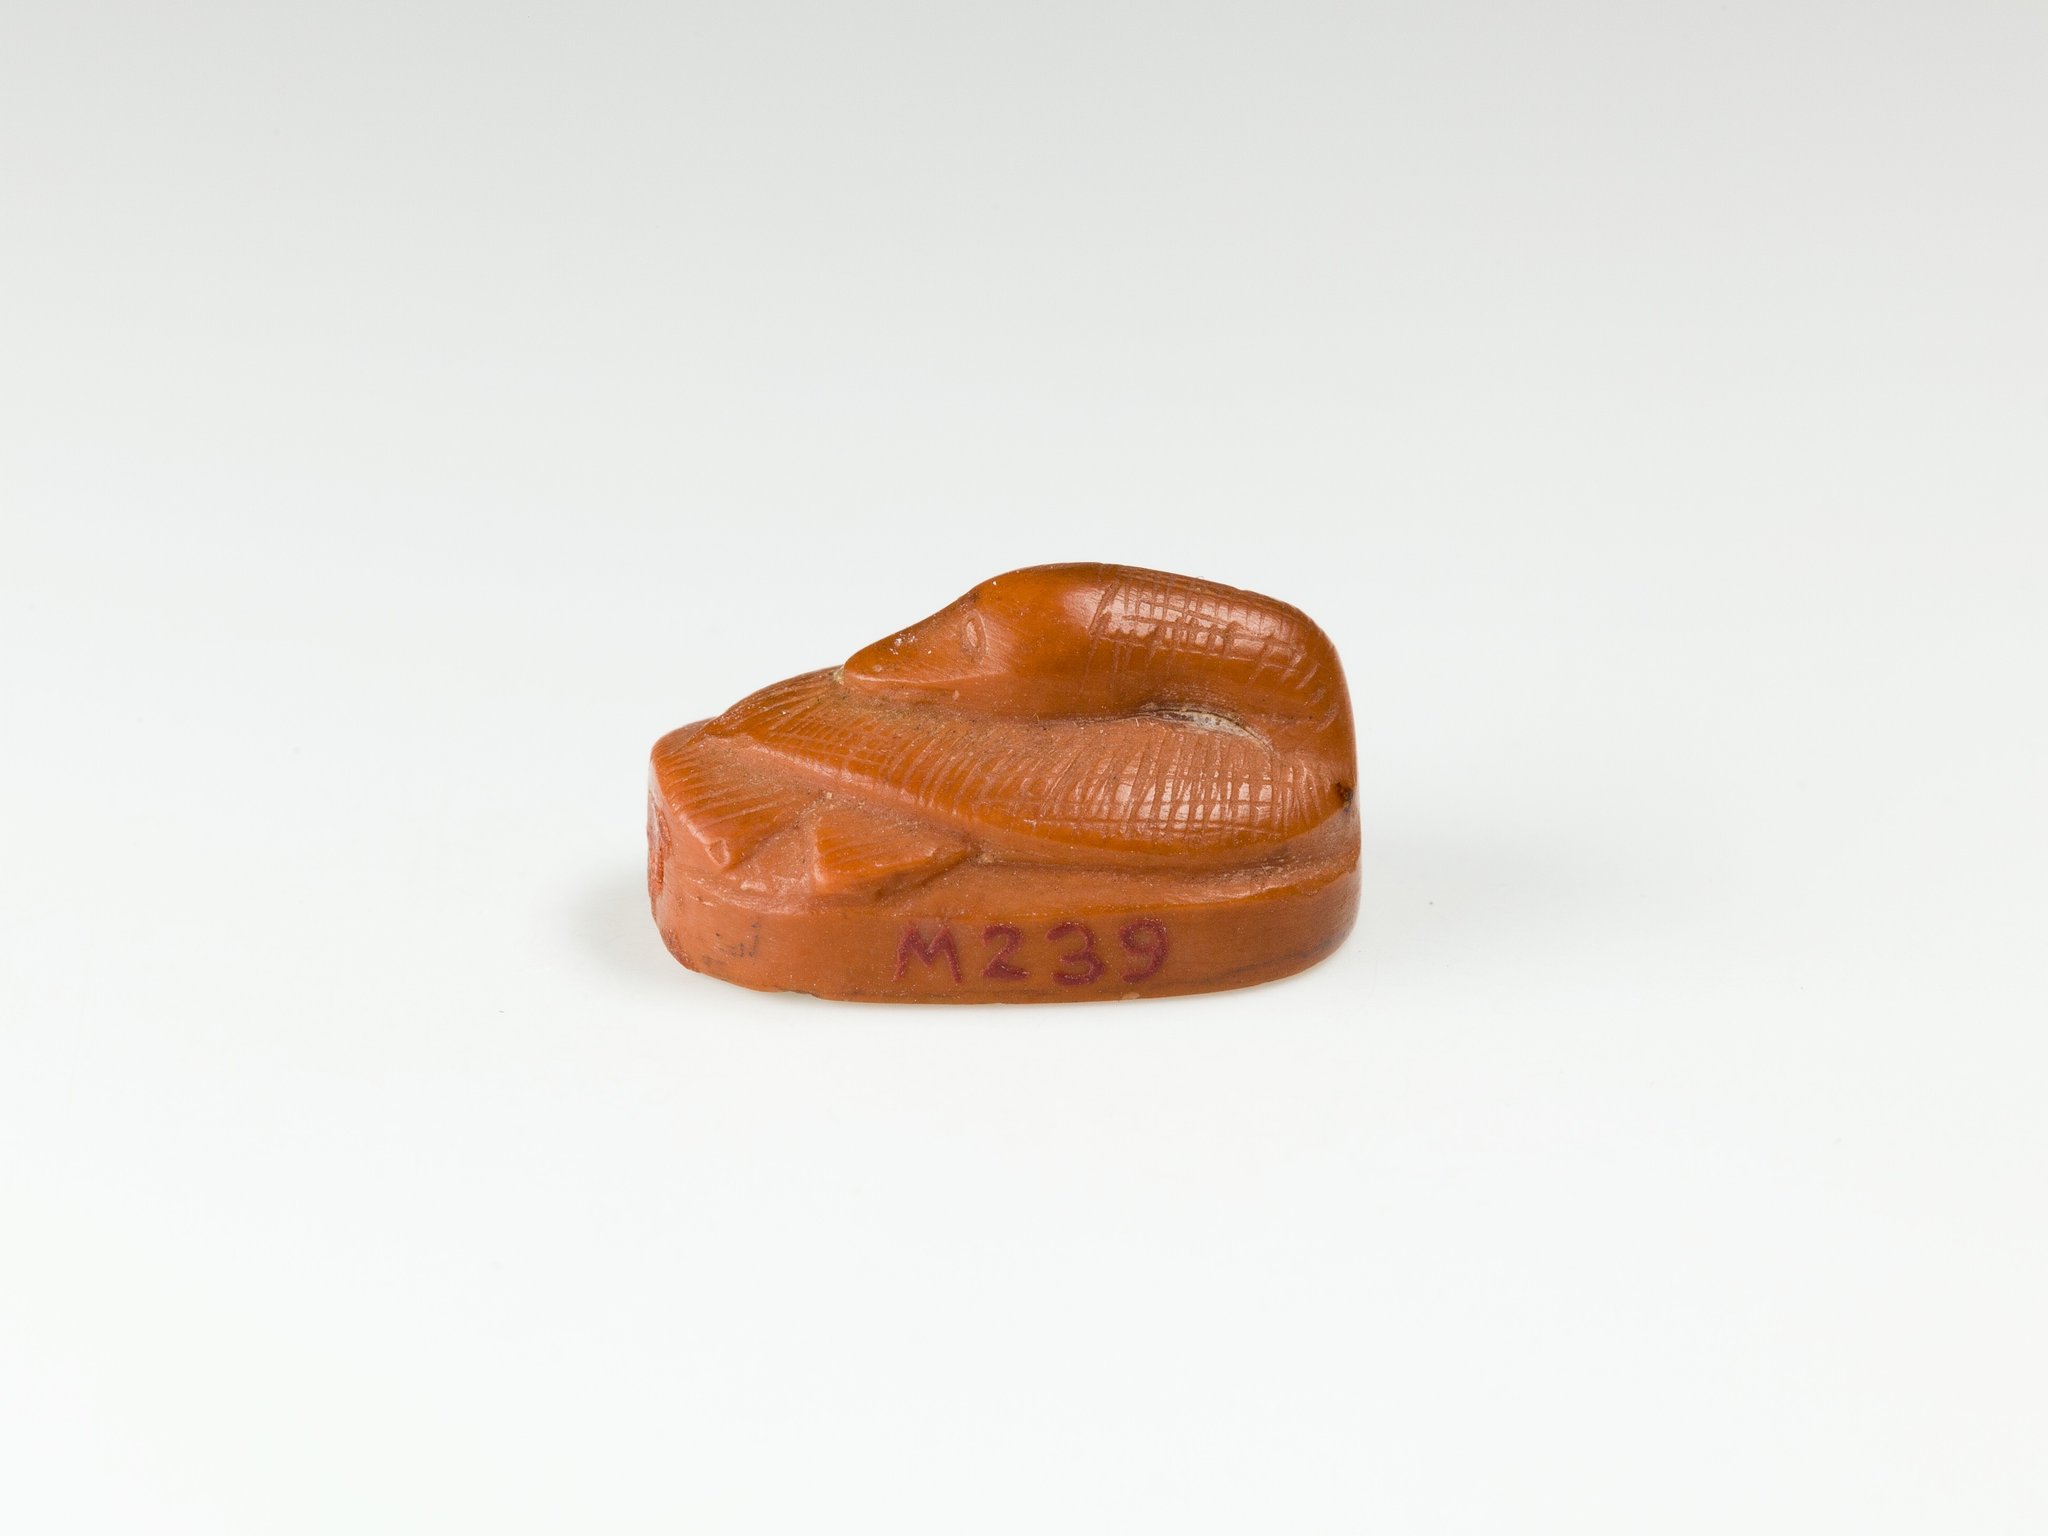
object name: bead plaque, ramesses ii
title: Bead Plaque of Ramesses II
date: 1295-1070 BCE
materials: jasper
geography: egypt